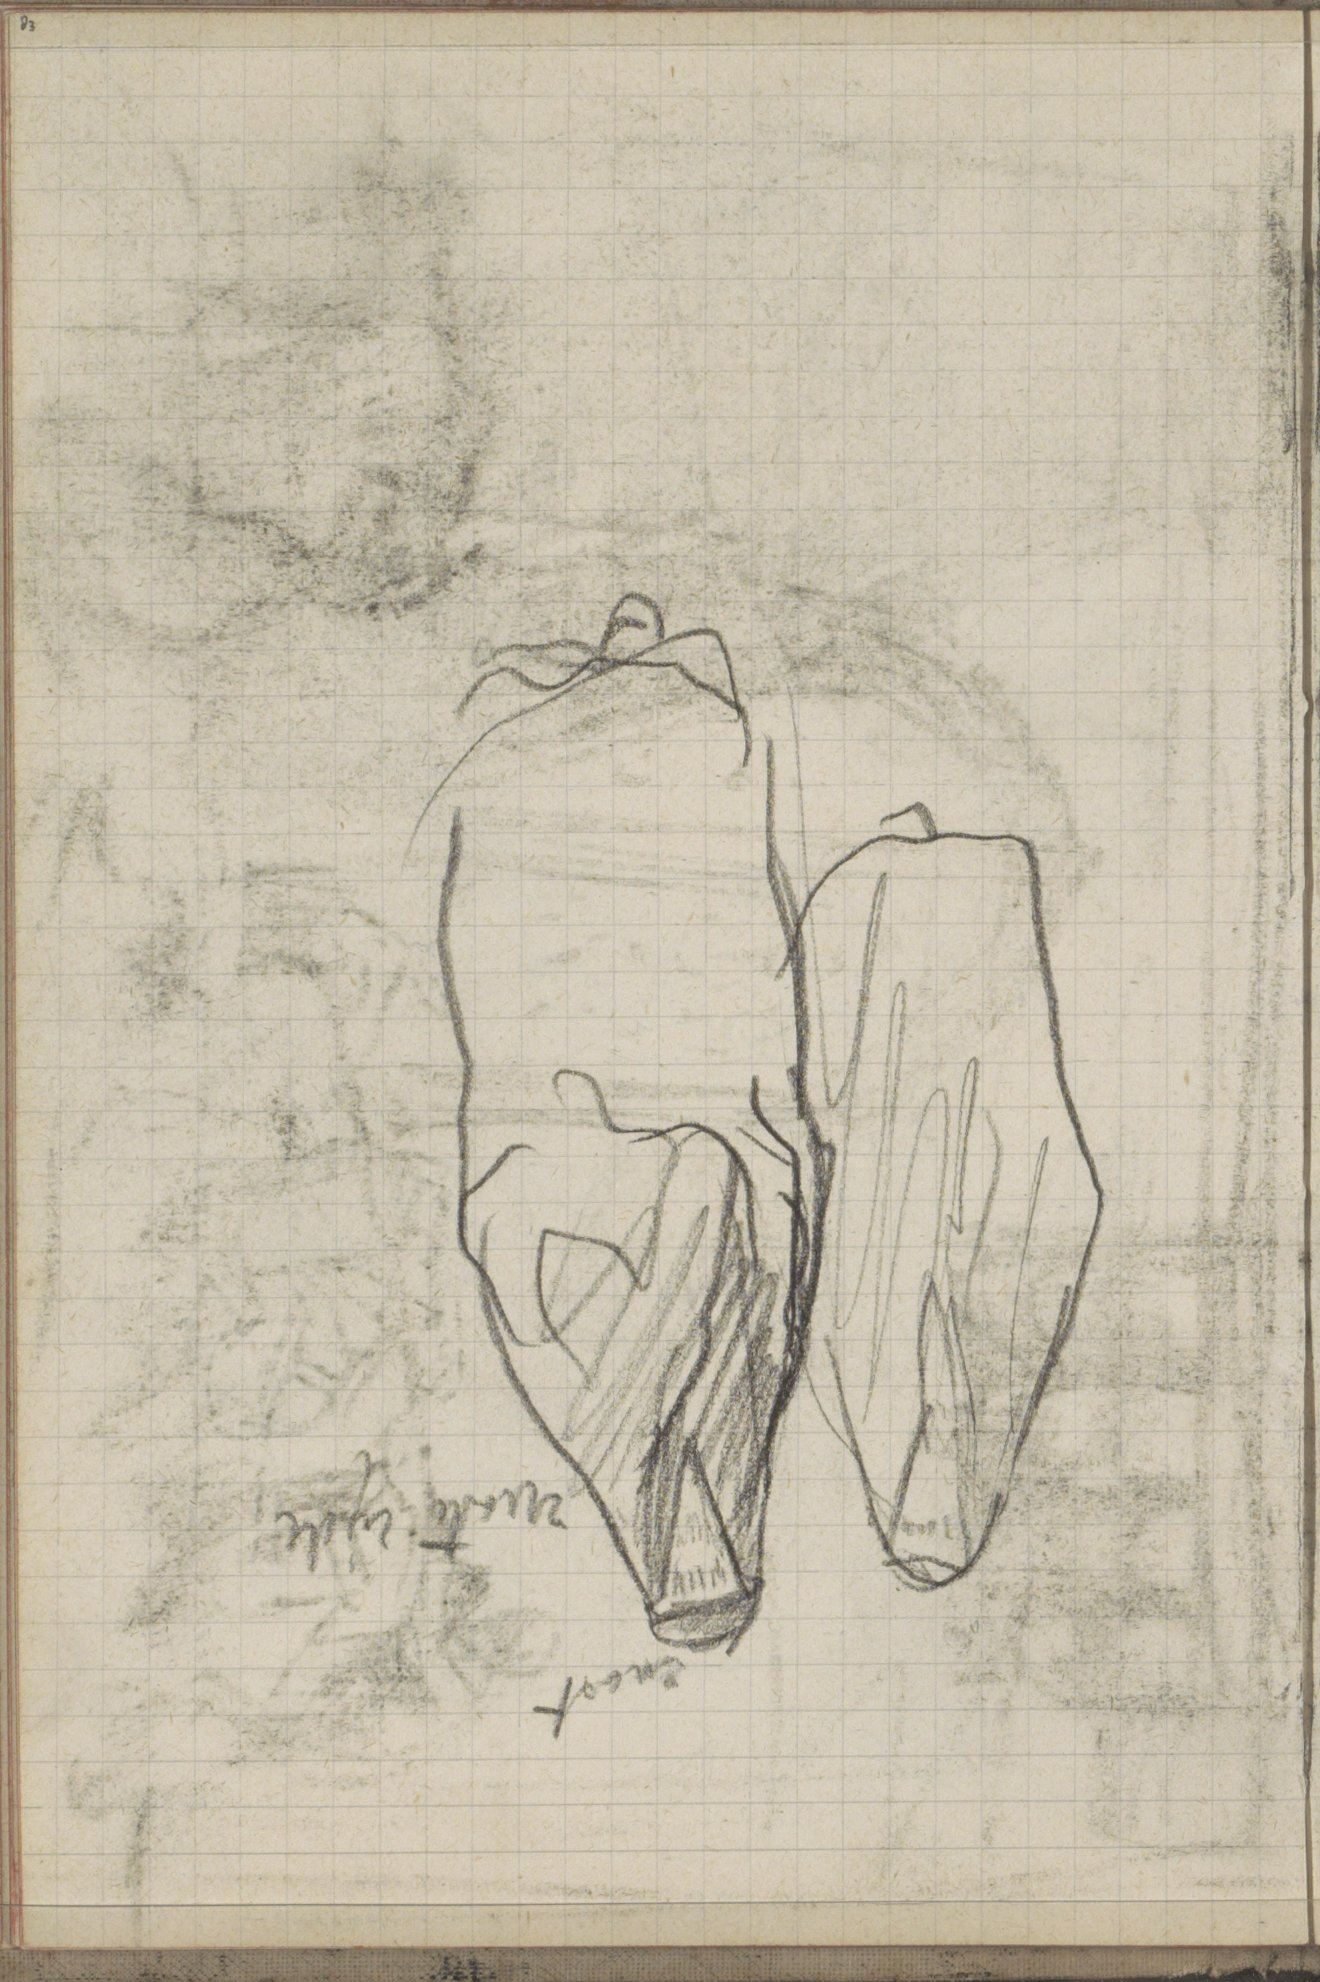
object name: sketchbook leaf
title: Twee staande figuren in oosterse kleding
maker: marius bauer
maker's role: draughtsman, print maker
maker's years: 1867-1932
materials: chalk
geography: istanbul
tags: asiatic races and peoples, standing figure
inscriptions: kleurnotitie, handgeschreven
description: Mogelijk vrouwen. De gewaden bedekken het gehele hoofd en lichaam. Pagina 83 uit een schetsboek met 54 bladen.